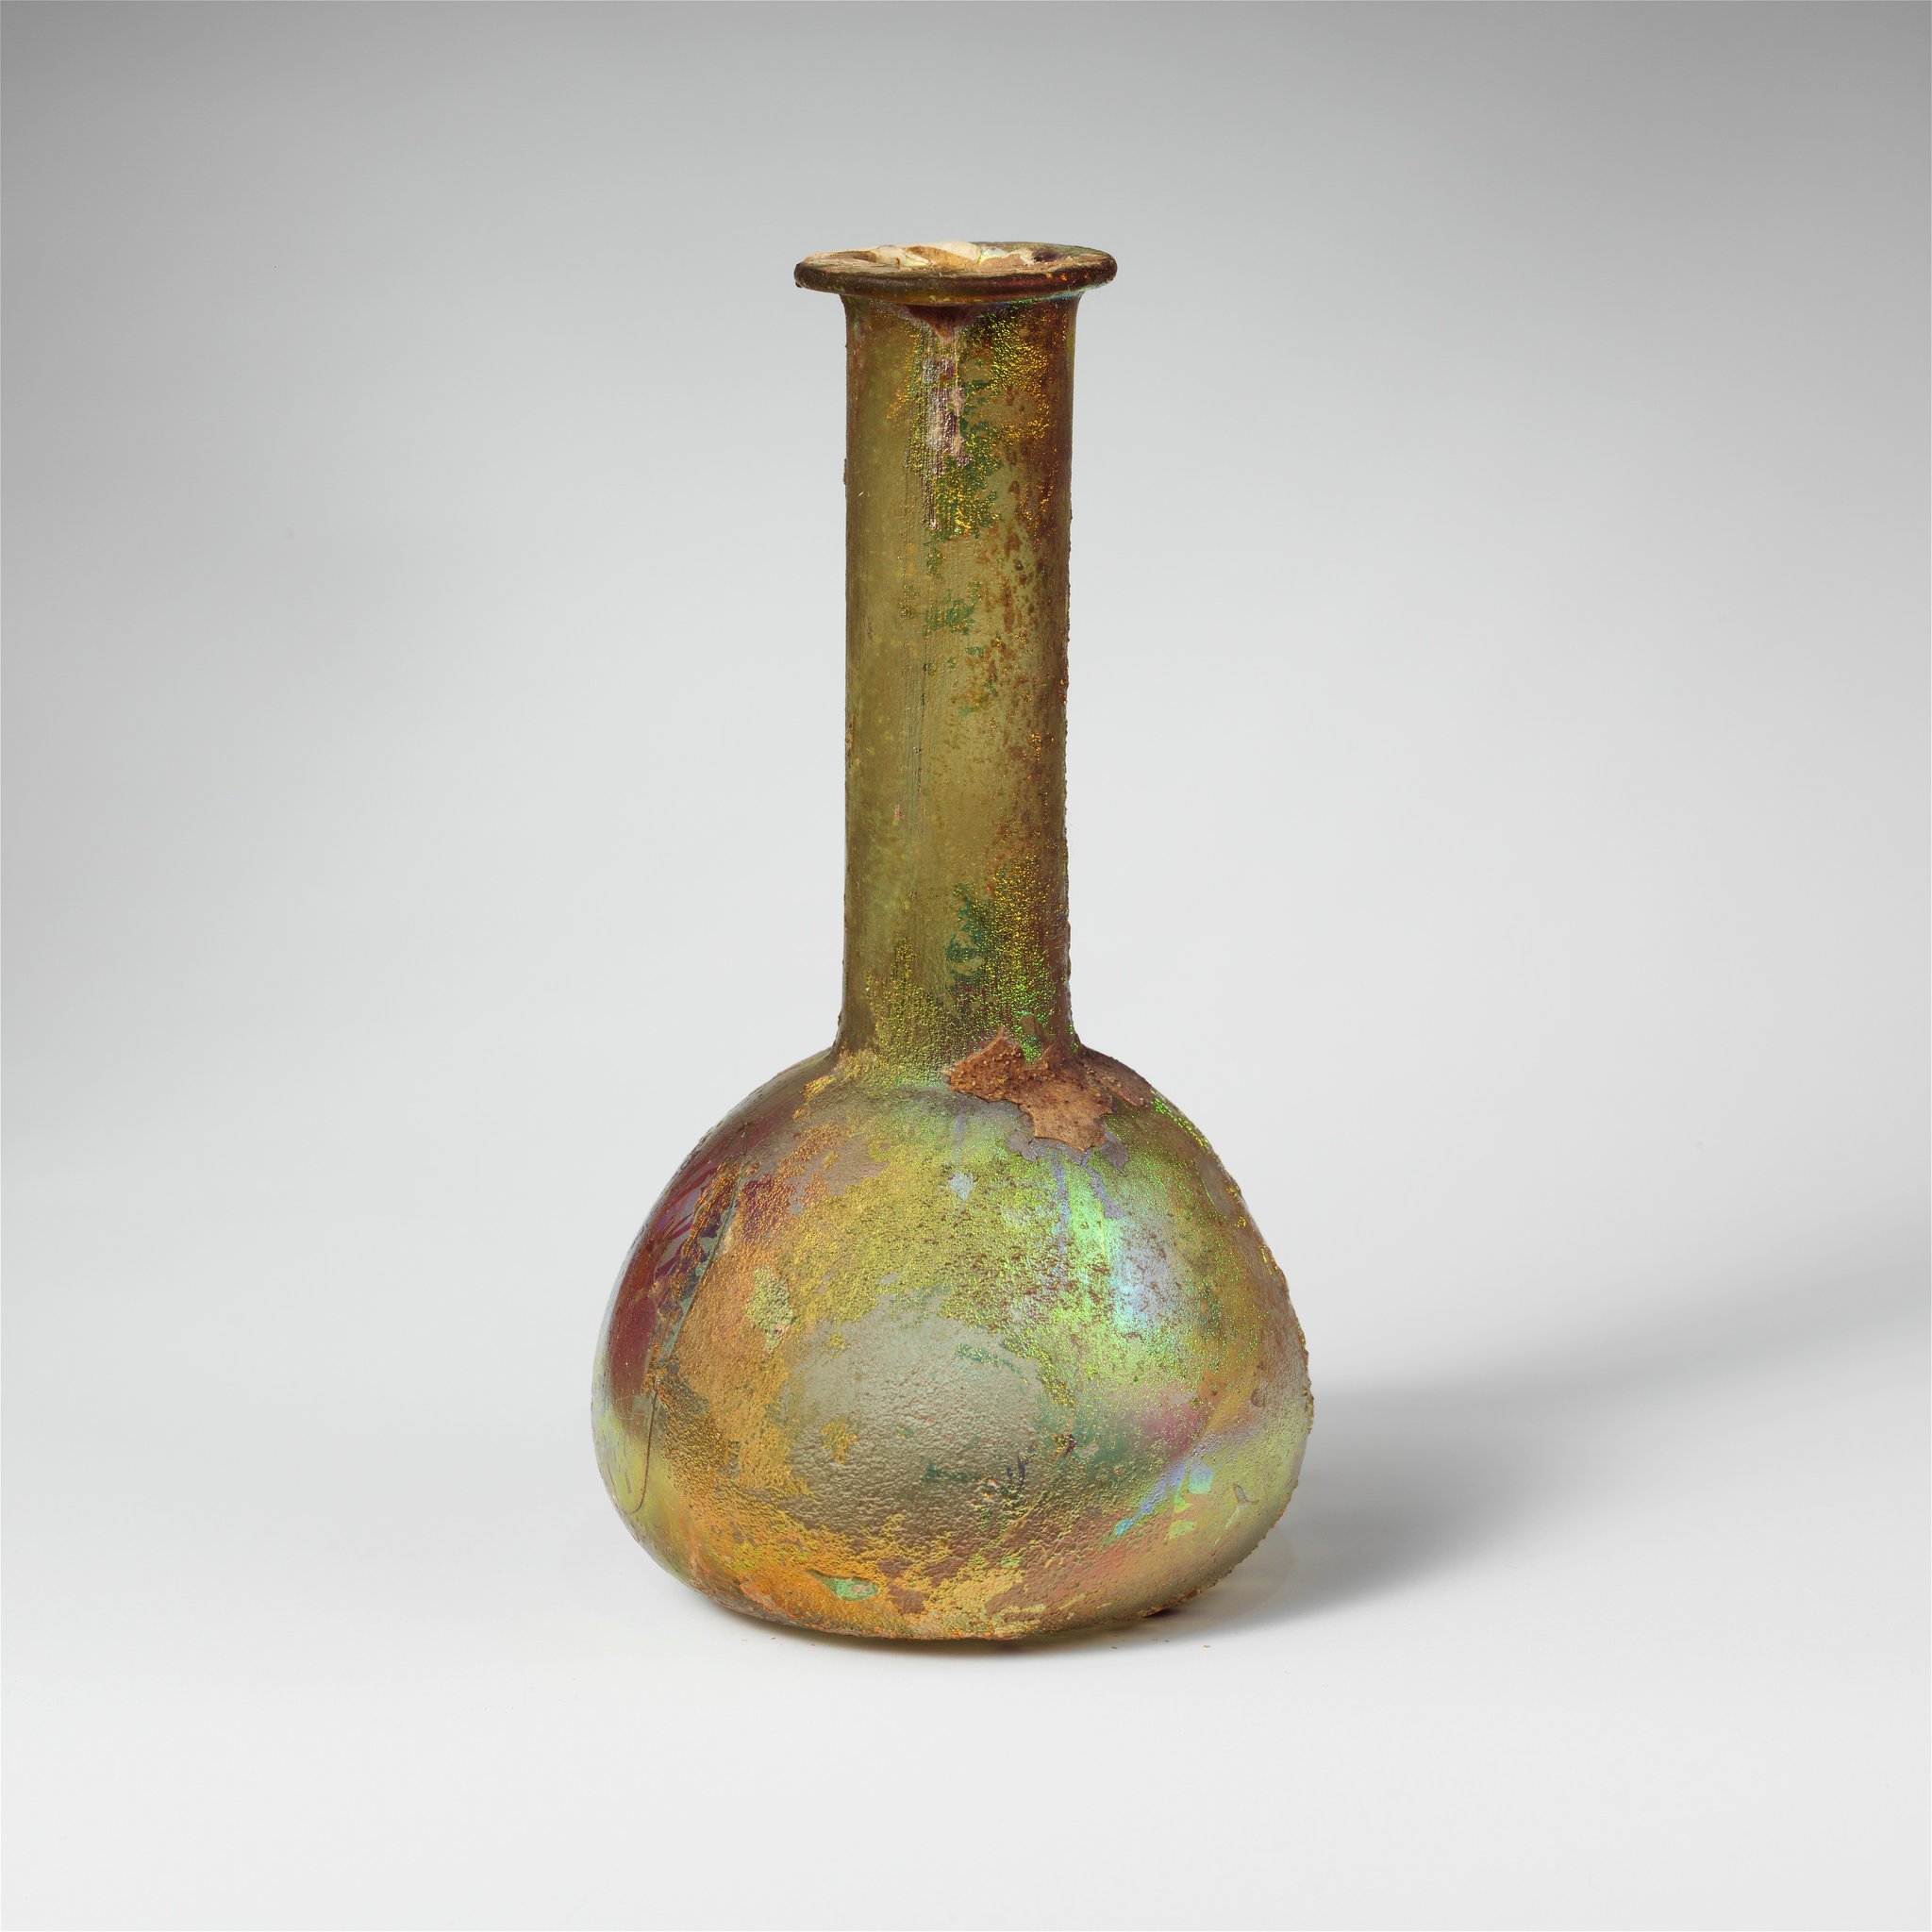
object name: perfume bottle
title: Glass perfume bottle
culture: roman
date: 101-300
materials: glass